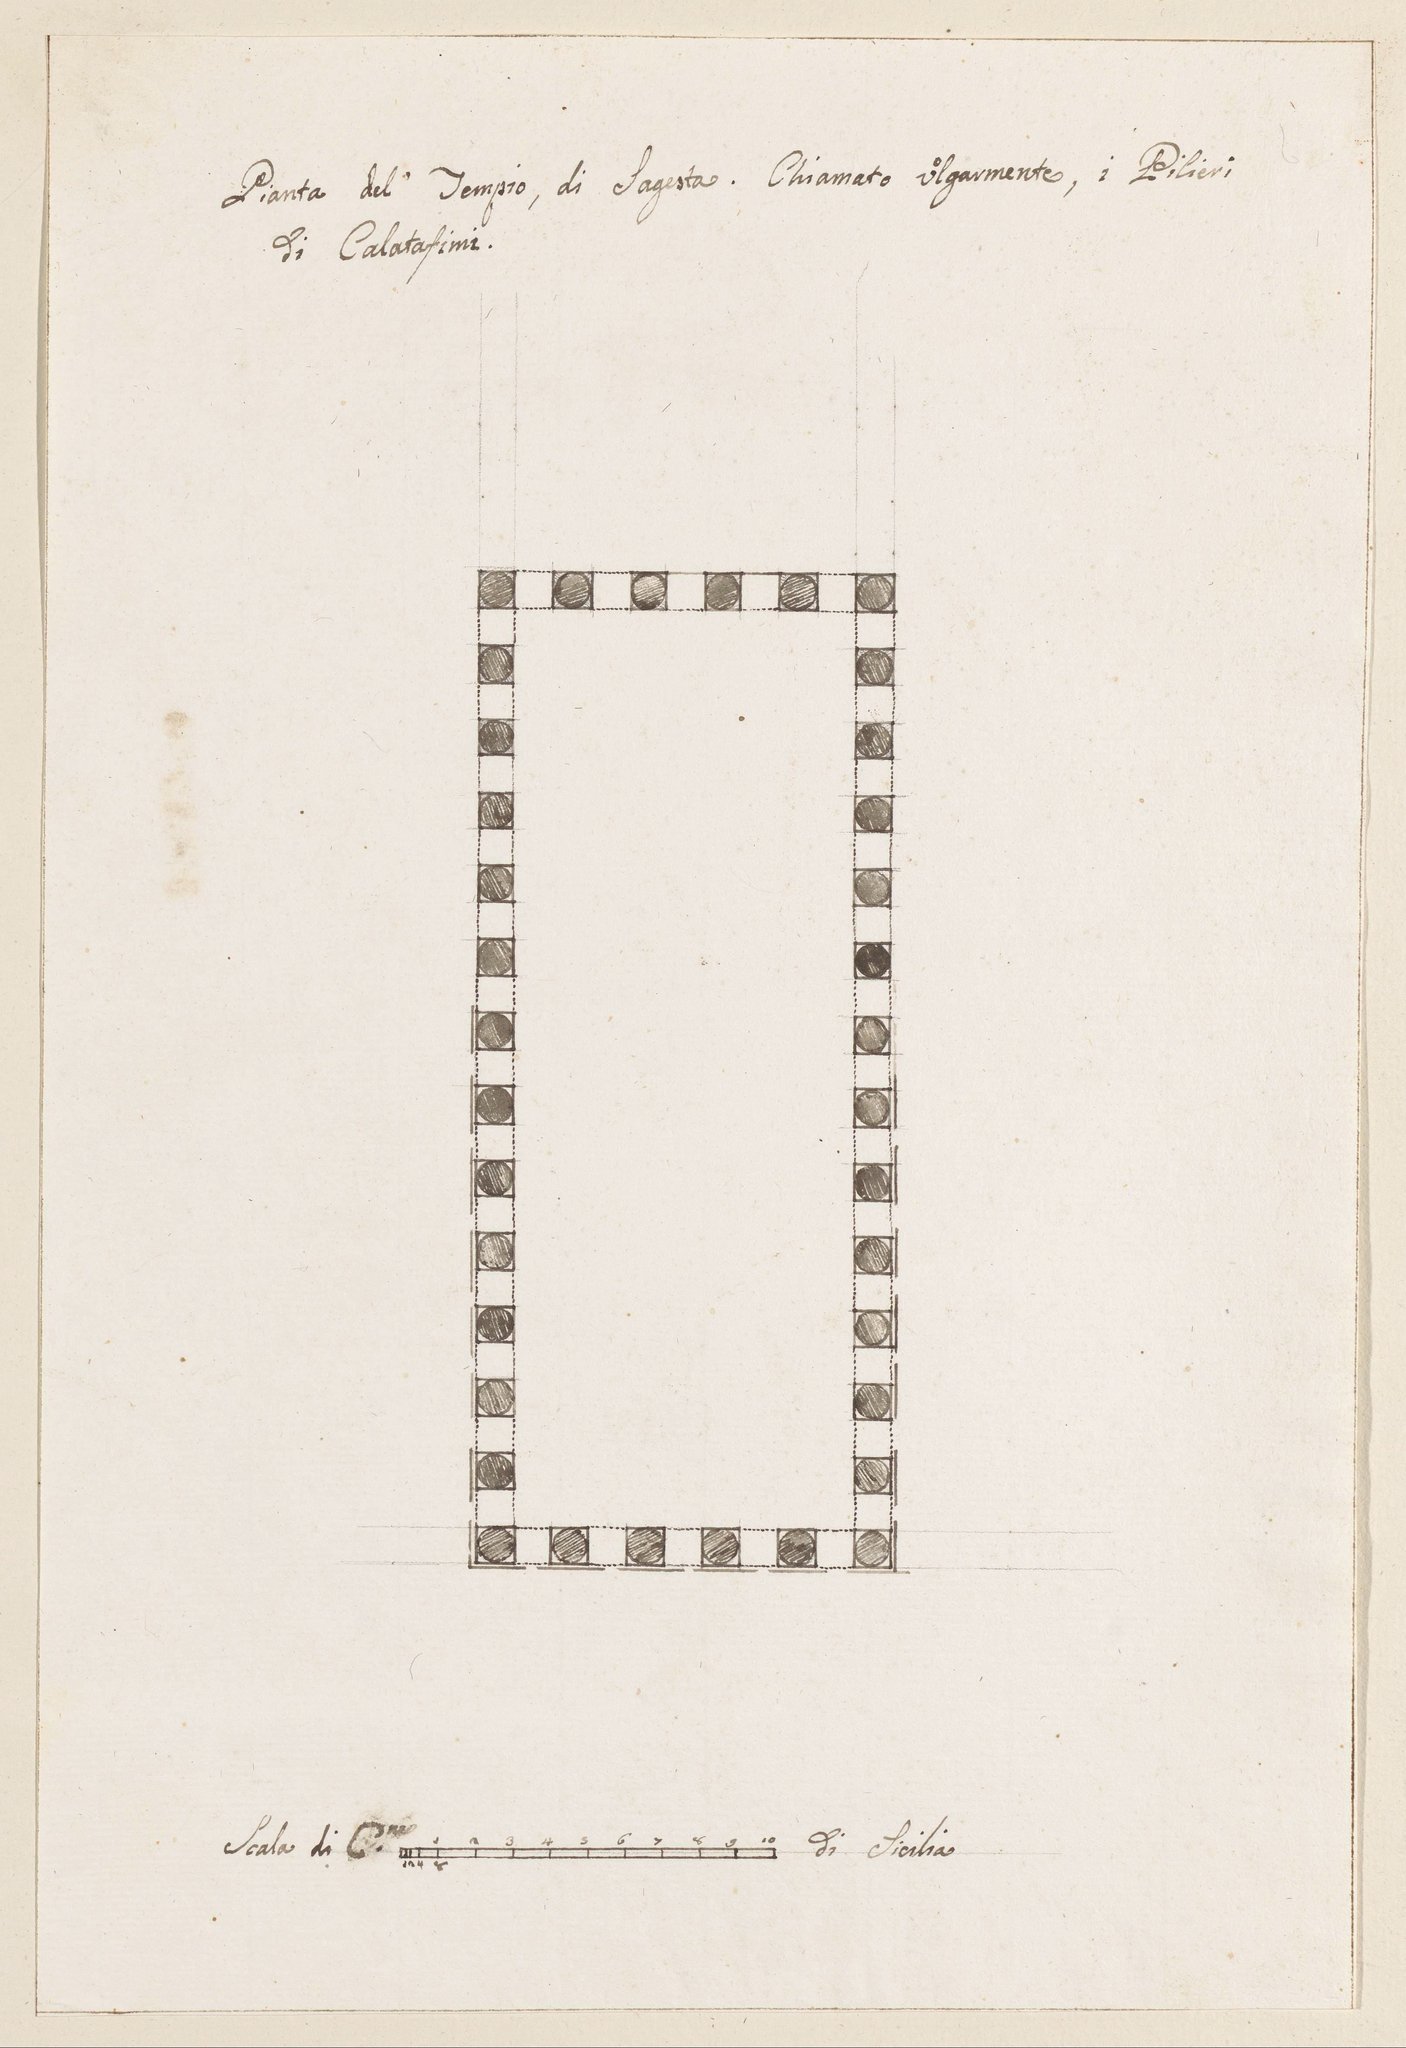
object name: drawing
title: Voyage en Italie, en Sicile et à Malte - 1778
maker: louis mayer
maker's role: draughtsman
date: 1778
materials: chalk, paper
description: De tempel van Segesta wordt in de volksmond Pilieri di Calatafimi genoemd aldus onderschrift in album nr. 3 van Nicolaas ten Hove. Hij vermeldt Louis Mayer als vervaardiger.